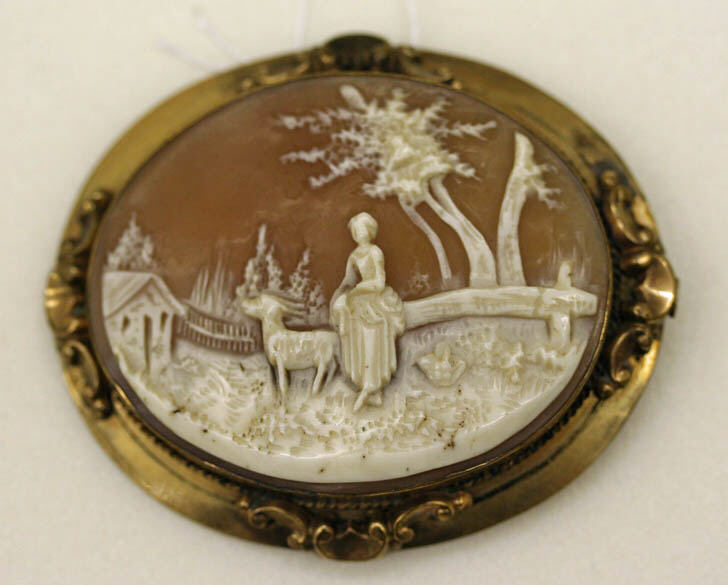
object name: brooch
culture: american or european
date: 1860-1869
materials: gold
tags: animals,women